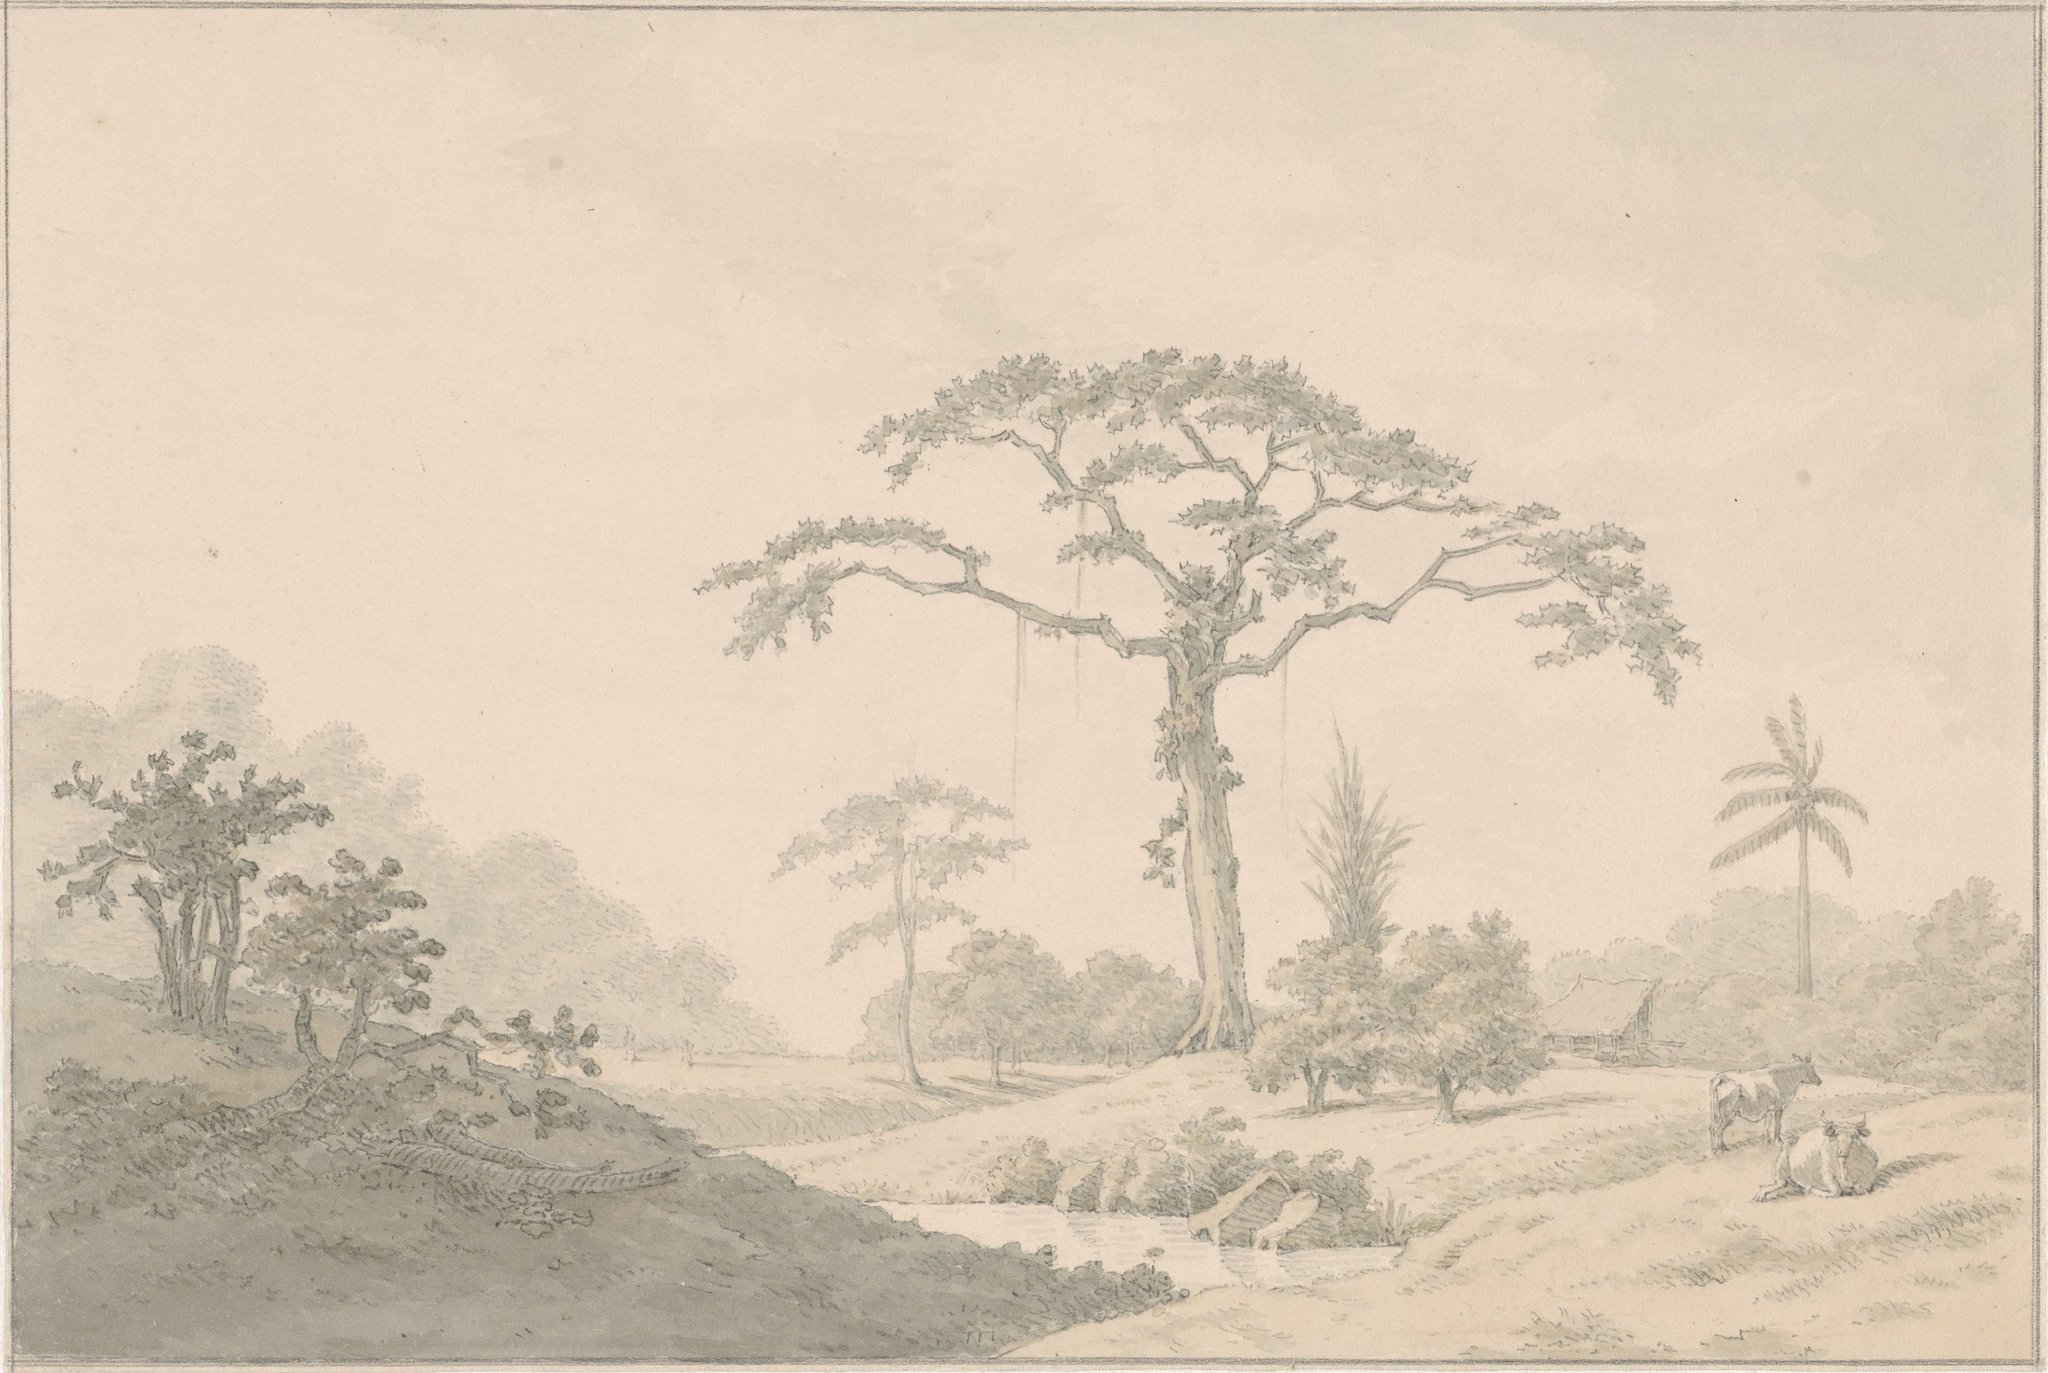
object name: drawing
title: Gezicht bij een hoeve in Suriname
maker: nicolaas box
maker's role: draughtsman, print maker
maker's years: 1785-1864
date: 1834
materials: paper, pencil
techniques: brush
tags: landscapes in tropical and sub-tropical regions, suriname